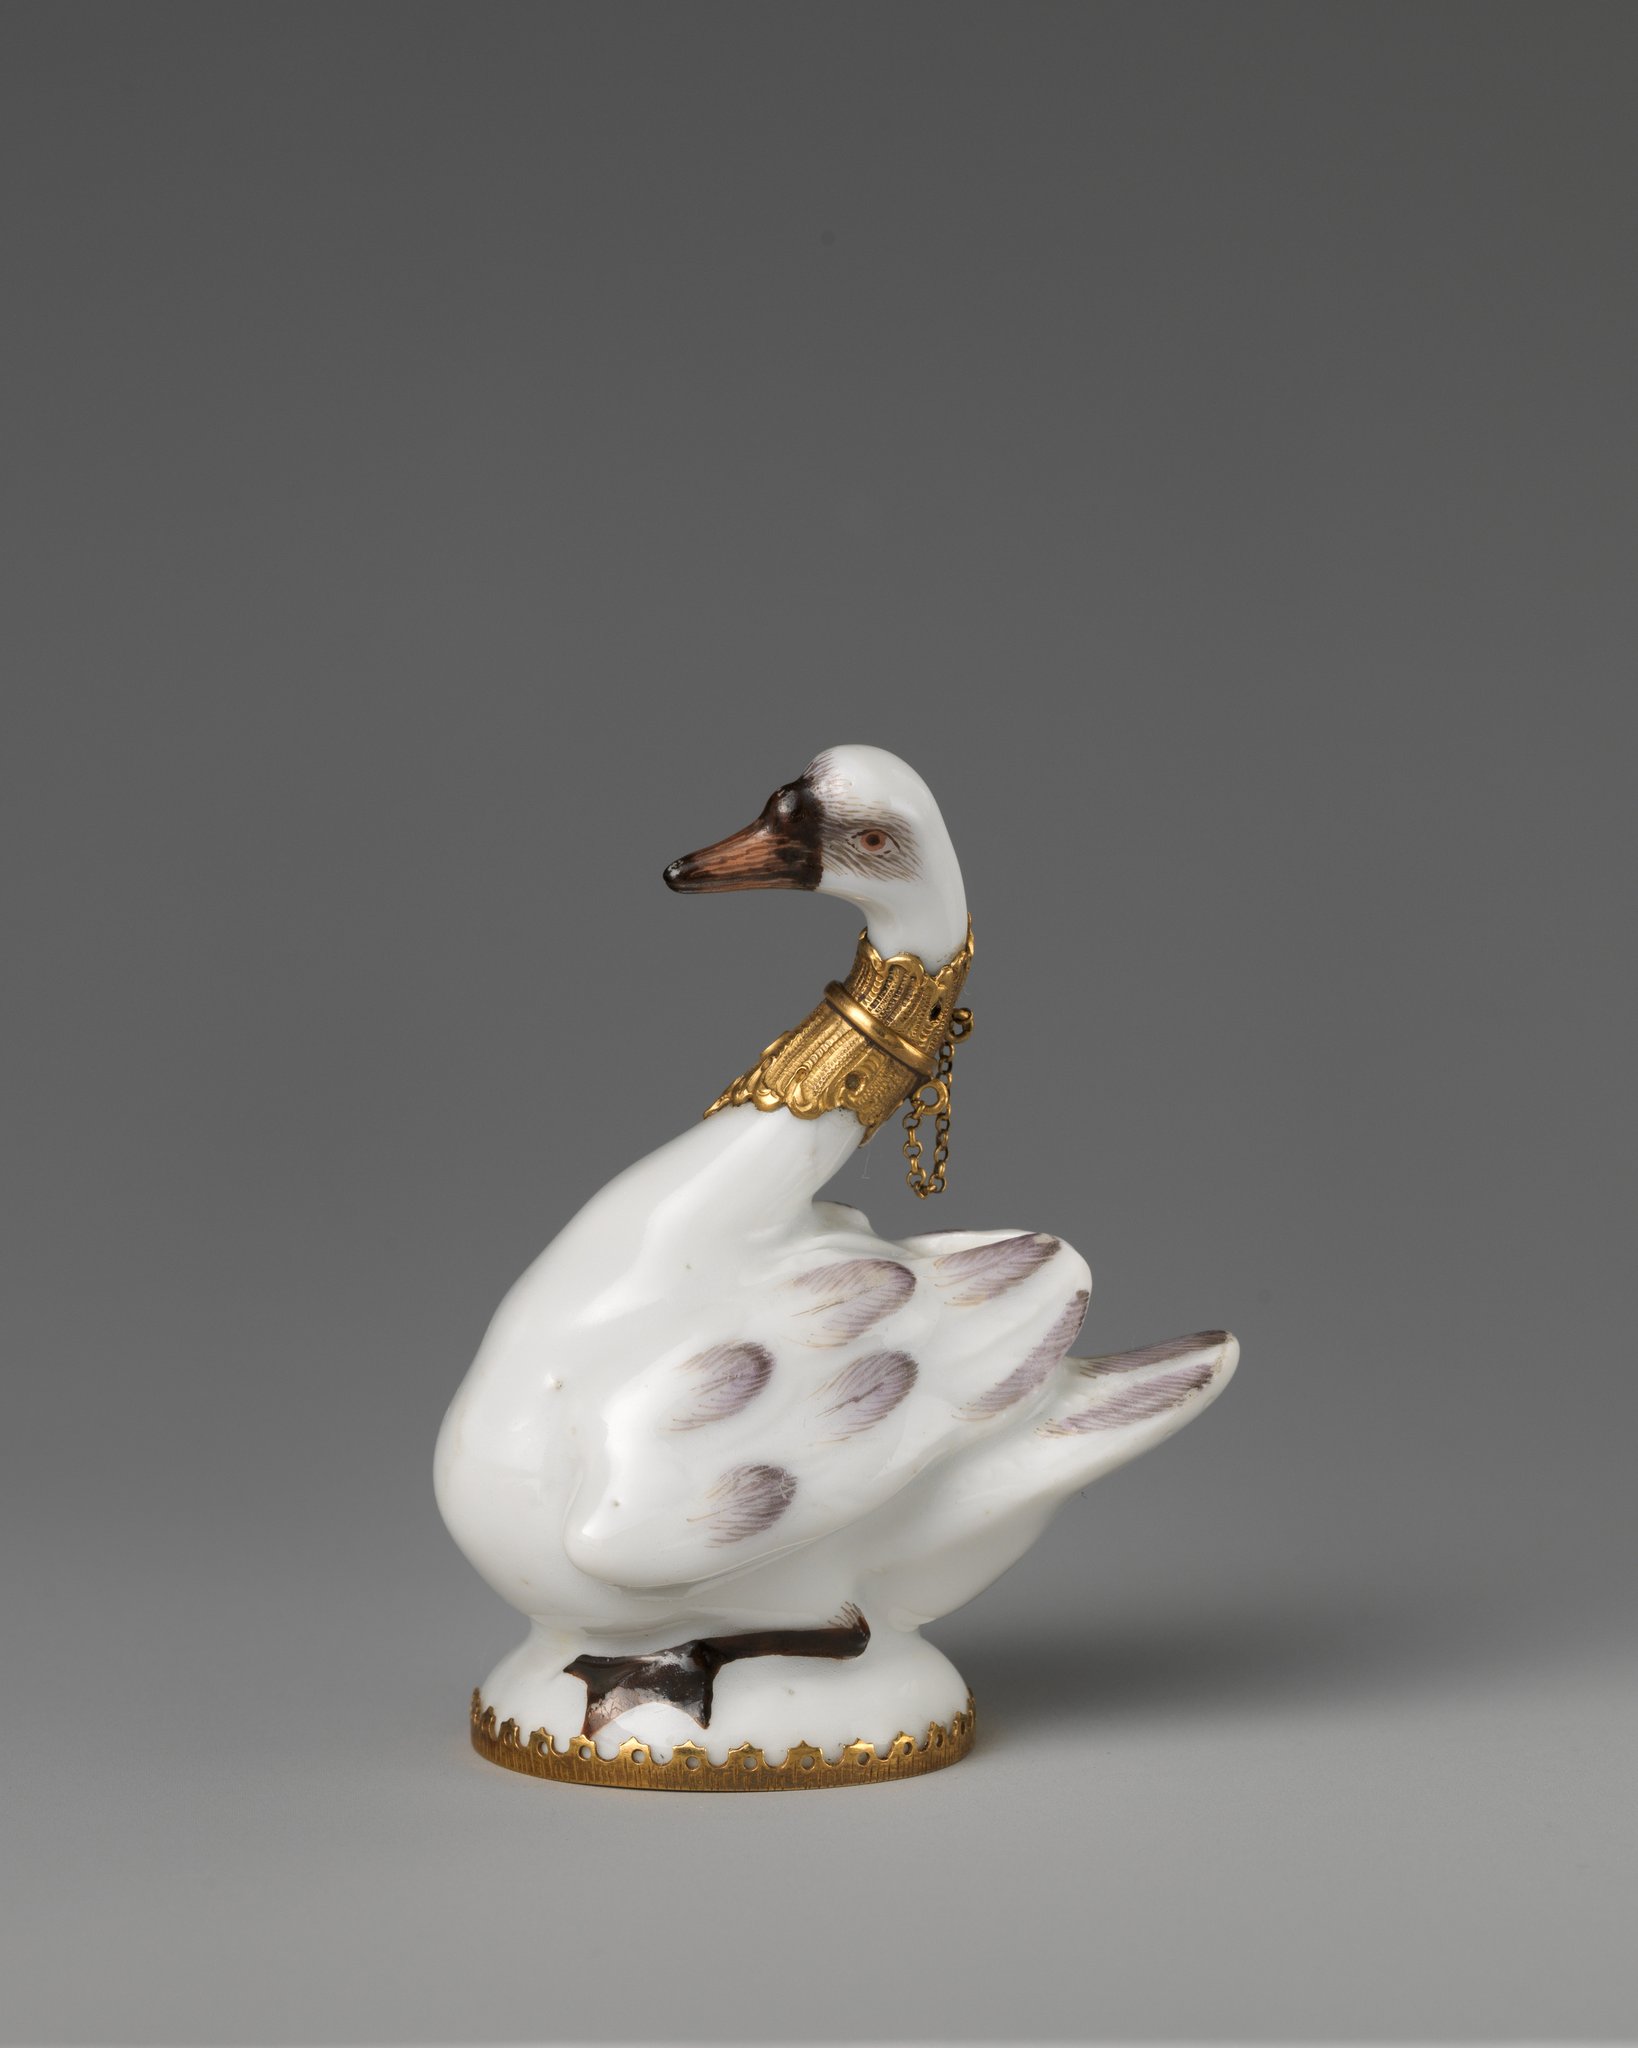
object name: toy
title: Swan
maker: chelsea porcelain manufactory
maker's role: factory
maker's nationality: british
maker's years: 1744-1784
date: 1755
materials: soft paste porcelain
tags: swans